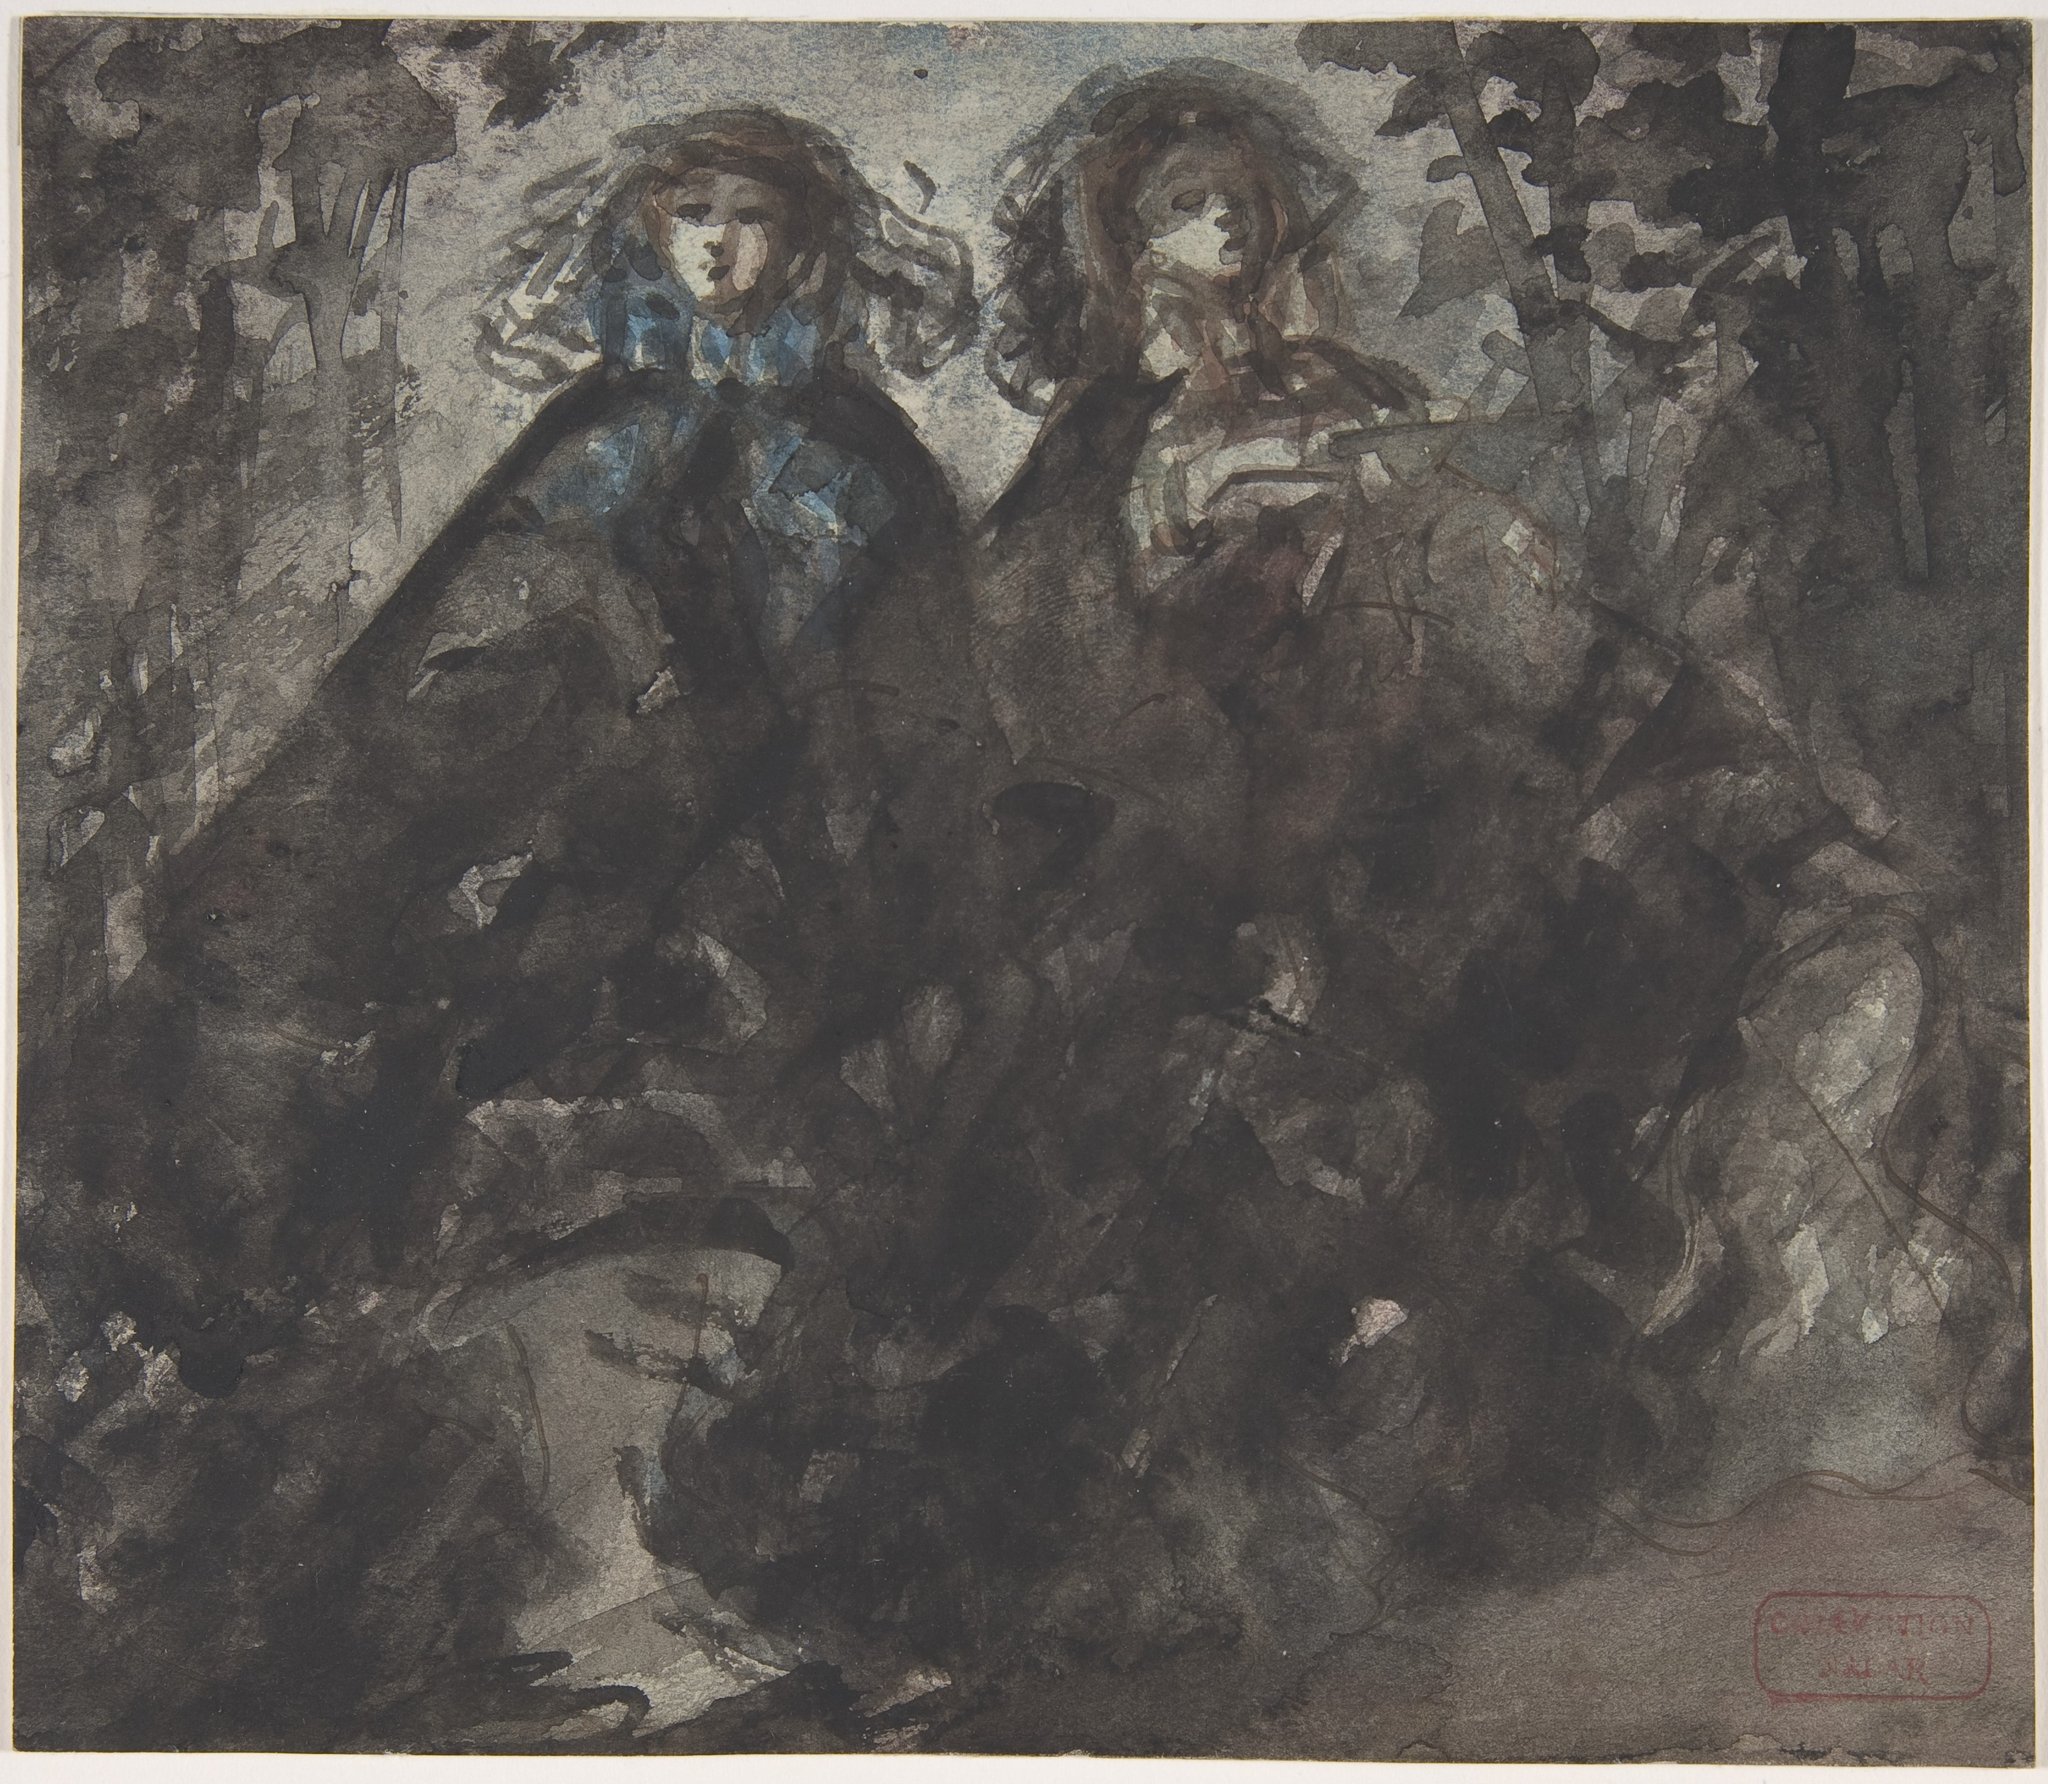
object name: drawing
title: Two Ladies Taking a Walk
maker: constantin guys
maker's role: artist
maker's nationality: french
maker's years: 1802-1892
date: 1801-1900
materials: ink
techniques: brush, pen, wash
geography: france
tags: women